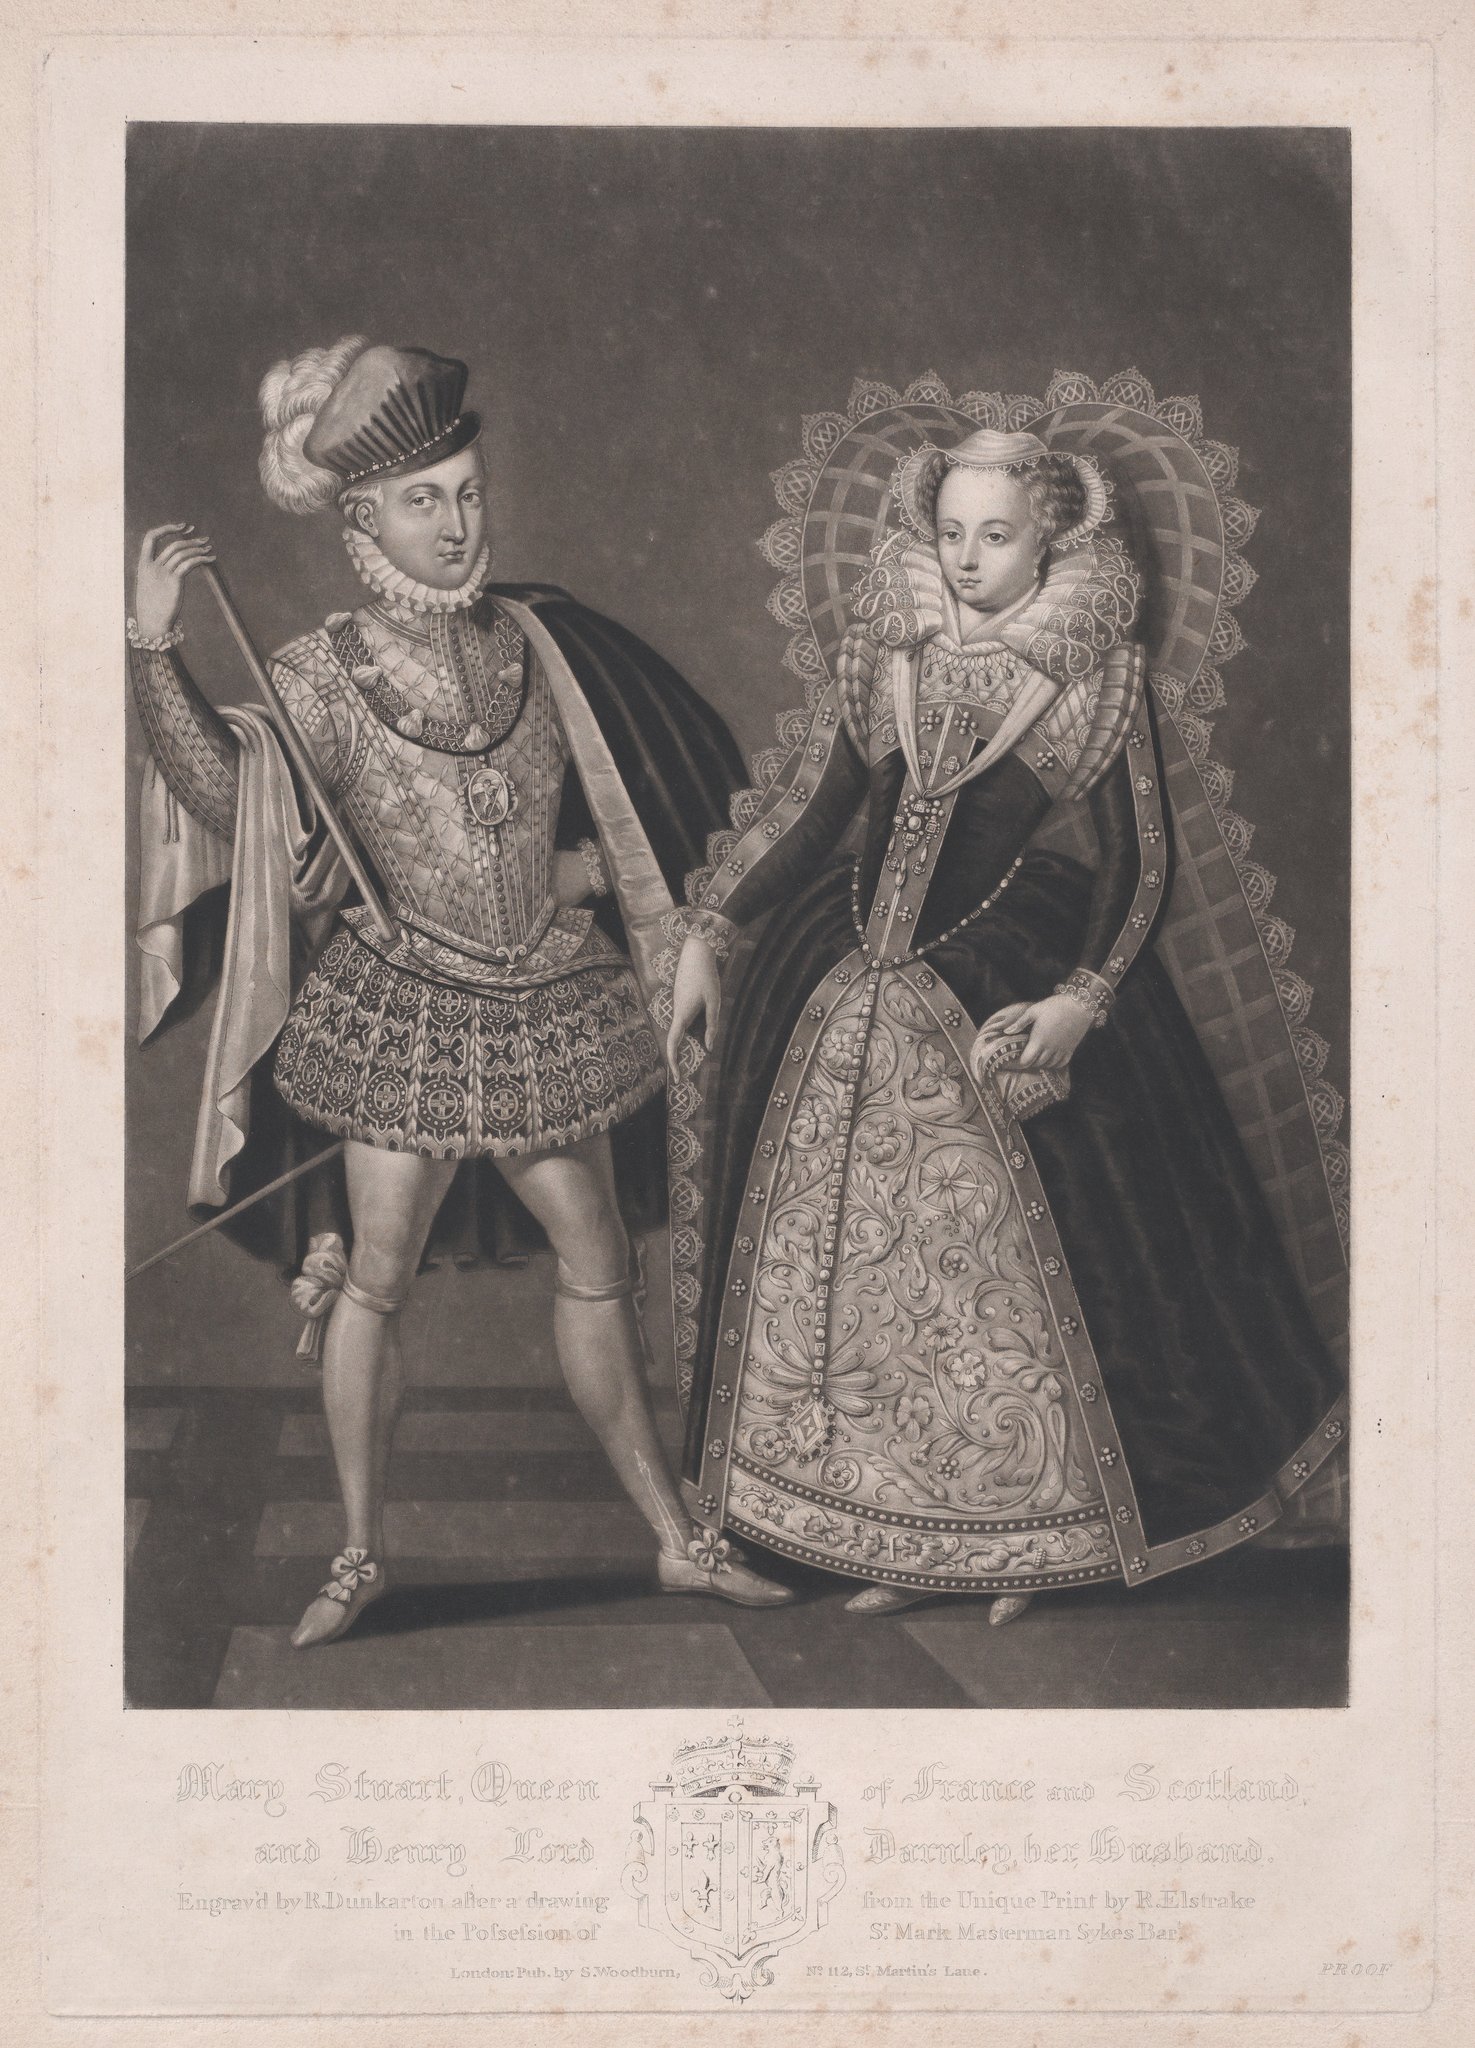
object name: print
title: Mary, Queen of Scots and Lord Darnley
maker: robert dunkarton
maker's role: engraver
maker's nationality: british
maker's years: 1744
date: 1816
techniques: mezzotint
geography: england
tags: queens,portraits,women,mary queen of scots